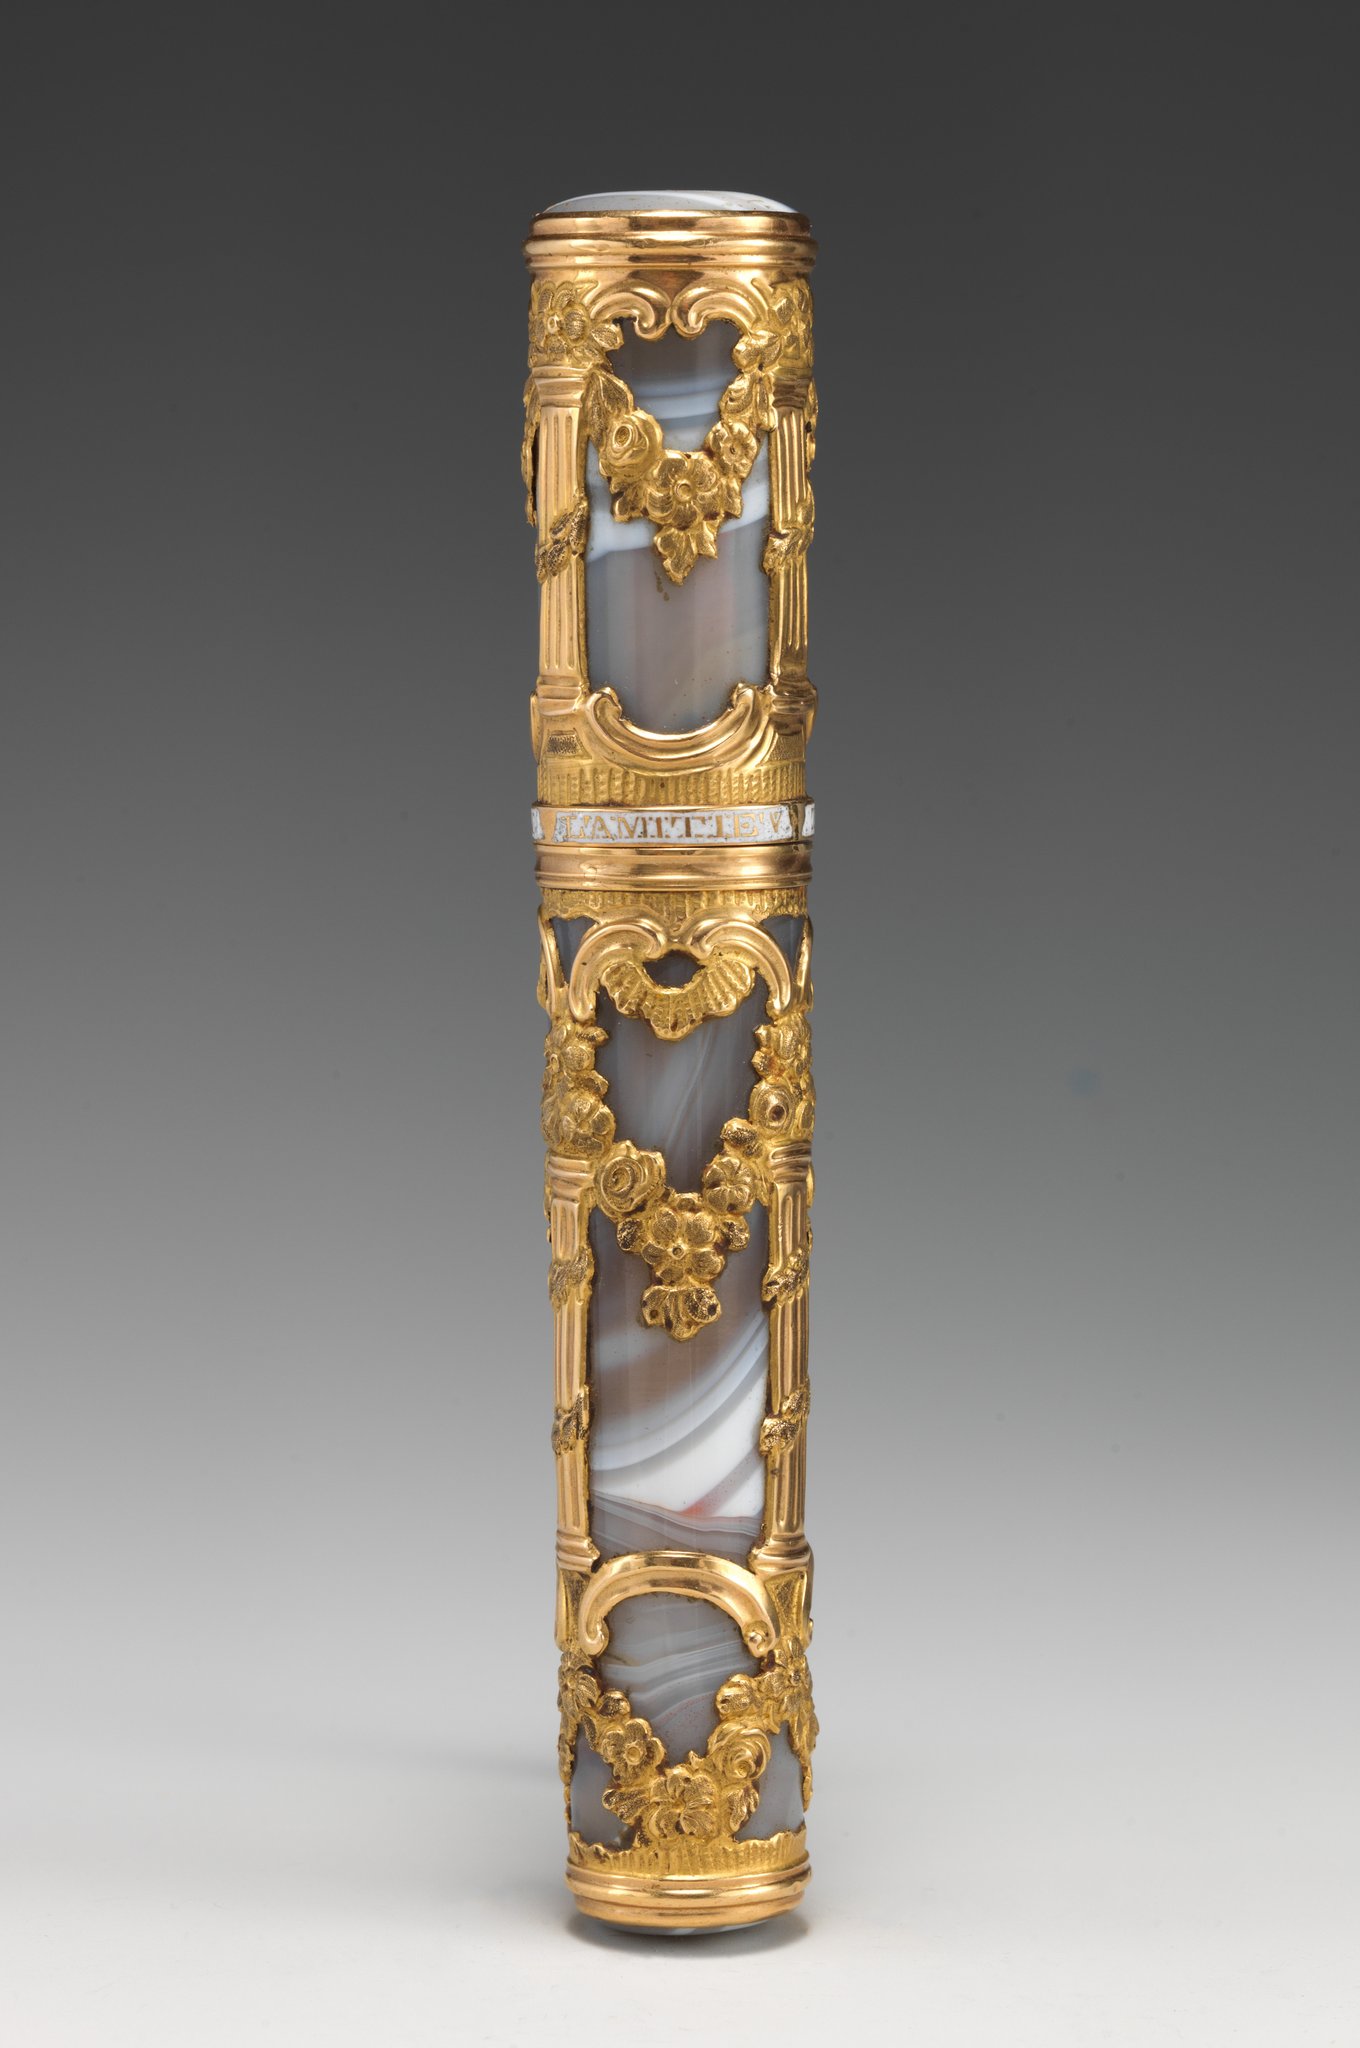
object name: étui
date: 1760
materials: stone, enamel, gold